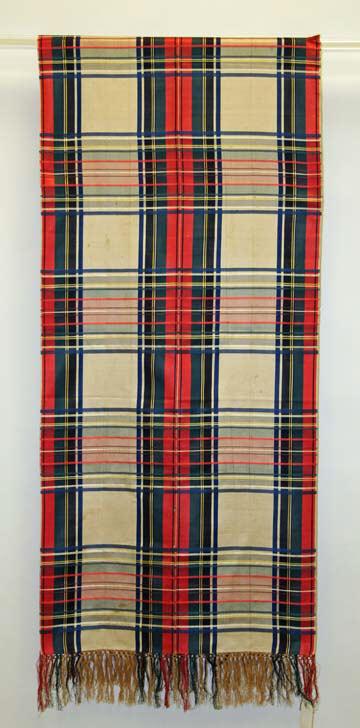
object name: shawl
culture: british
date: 1822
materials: silk